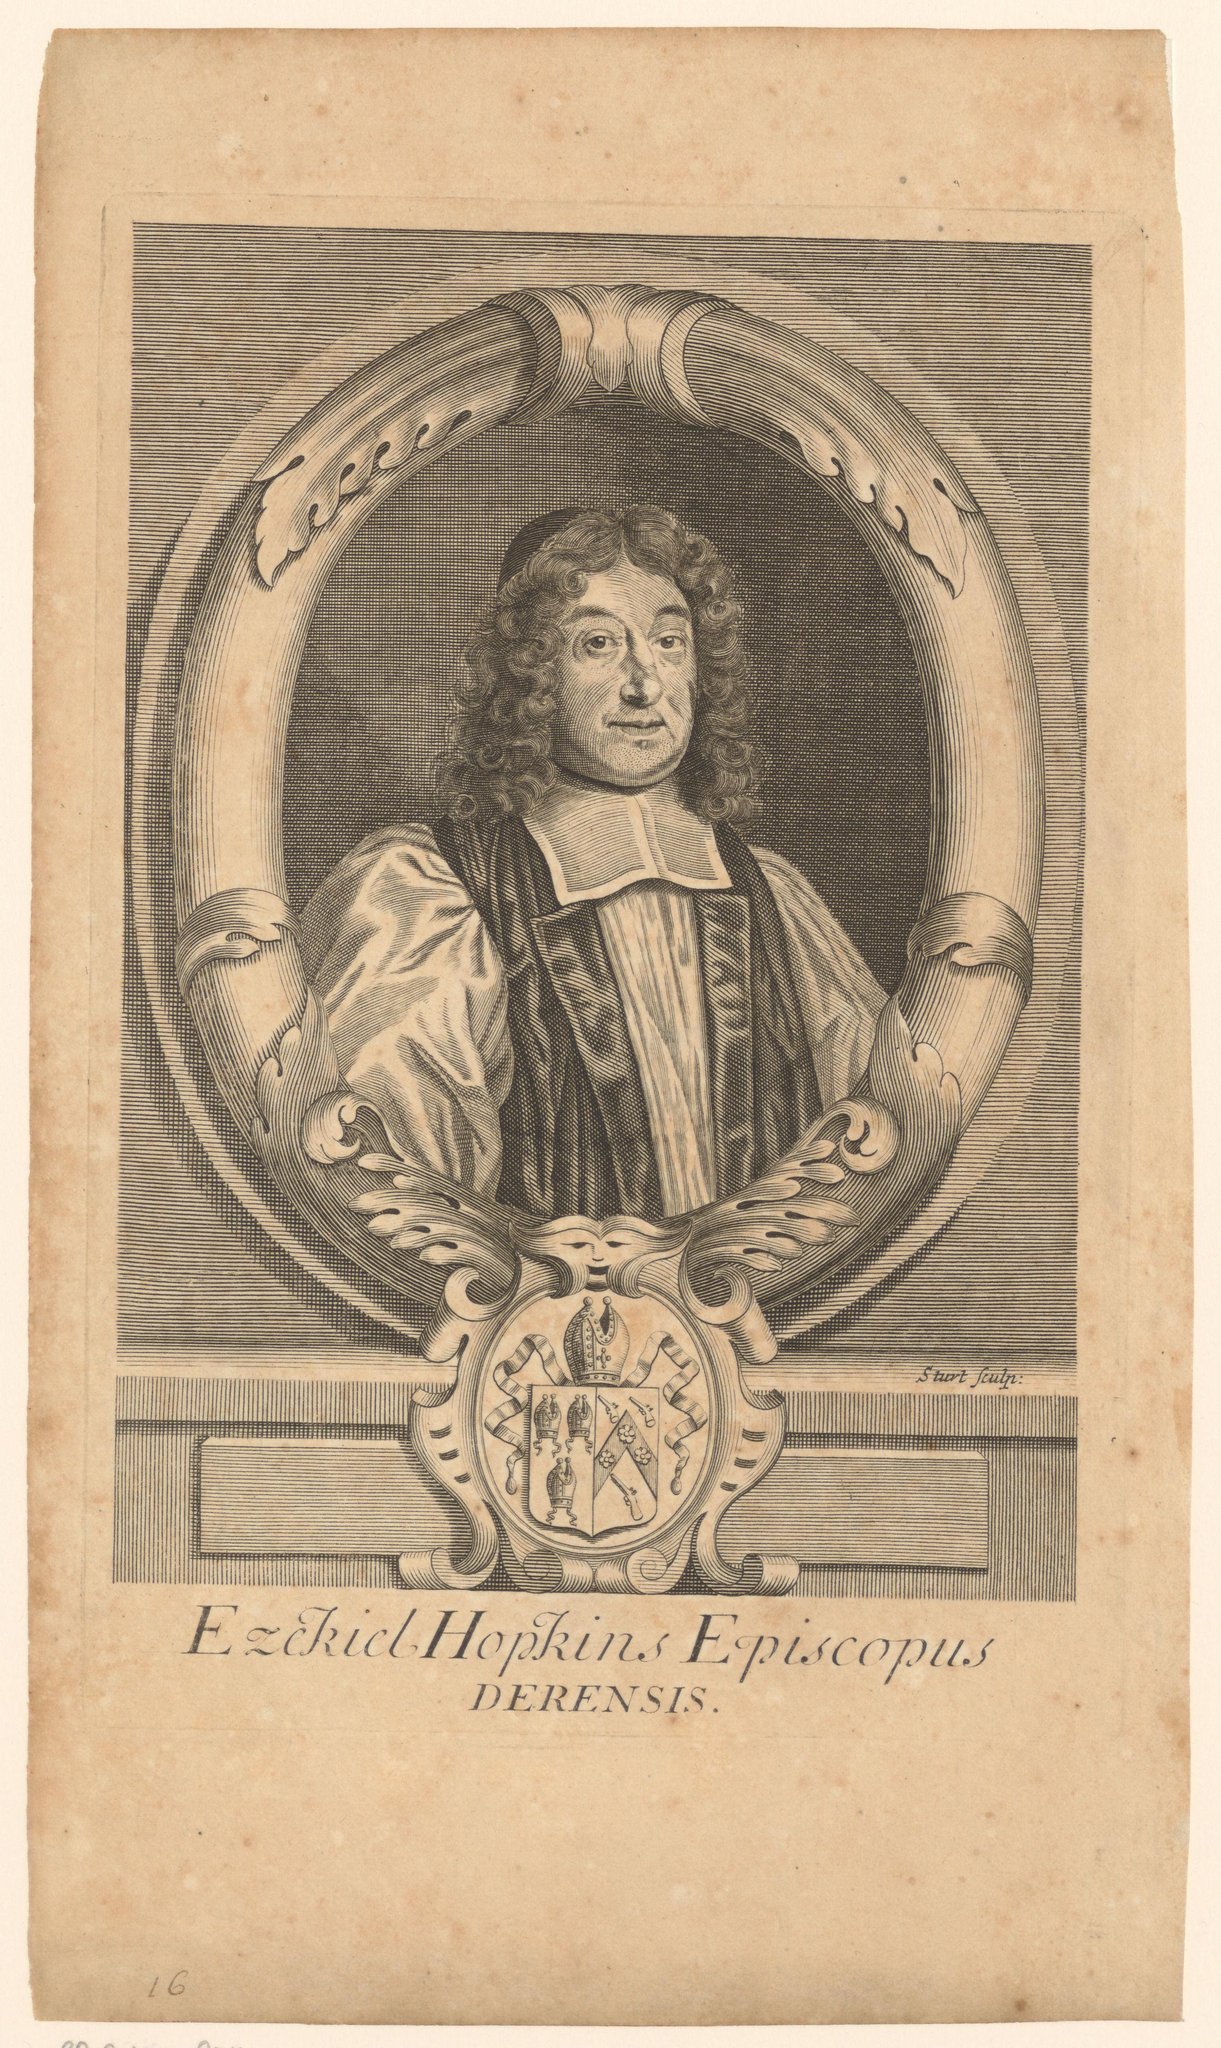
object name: print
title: Portret van Ezekiel Hopkins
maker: john sturt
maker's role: print maker, publisher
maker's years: 1658-1730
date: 1691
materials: paper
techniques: engraving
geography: london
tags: archbishop, bishop, etc. (roman catholic), historical persons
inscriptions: collector's mark: Lugt 2228